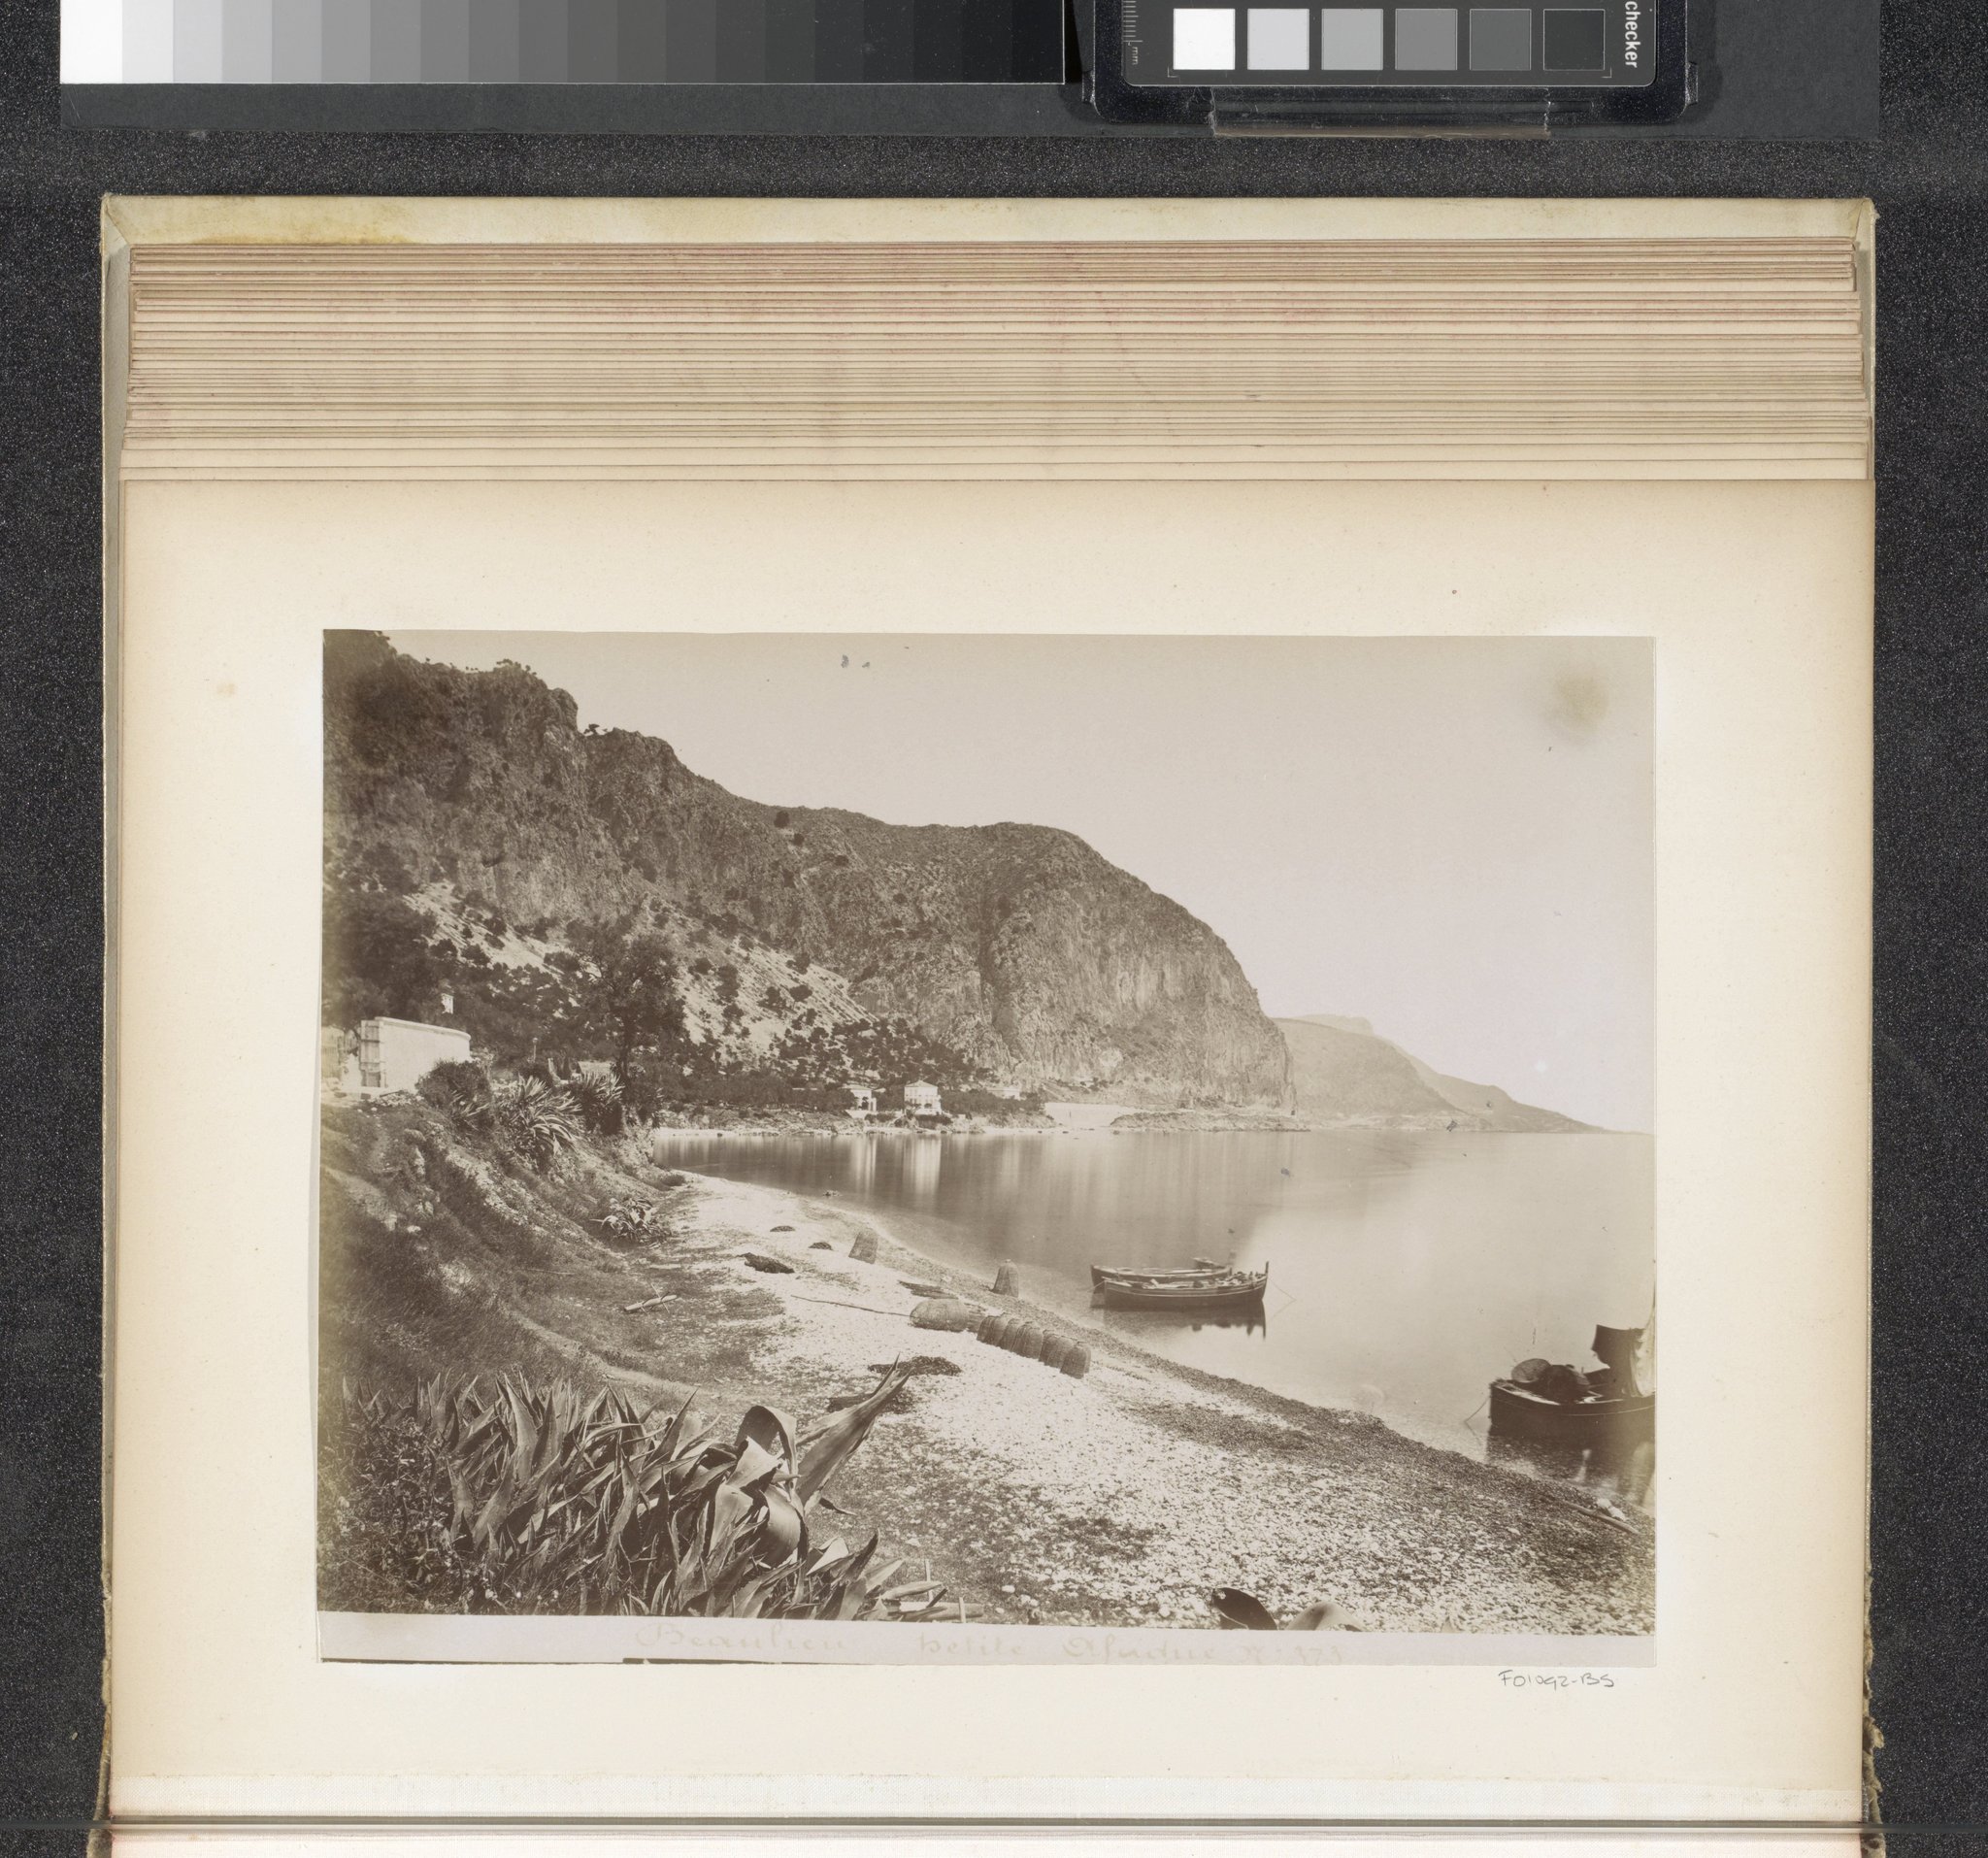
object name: photograph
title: Beaulieu Petite Afrique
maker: Anonymous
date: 1880-1900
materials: cardboard, paper, photographic support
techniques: albumen print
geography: beaulieu-sur-mer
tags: gulf, bay (+ landscape with figures, staffage)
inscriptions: negative number: ‘373’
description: Onderdeel van Reisalbum met foto's van bezienswaardigheden in België en Frankrijk.